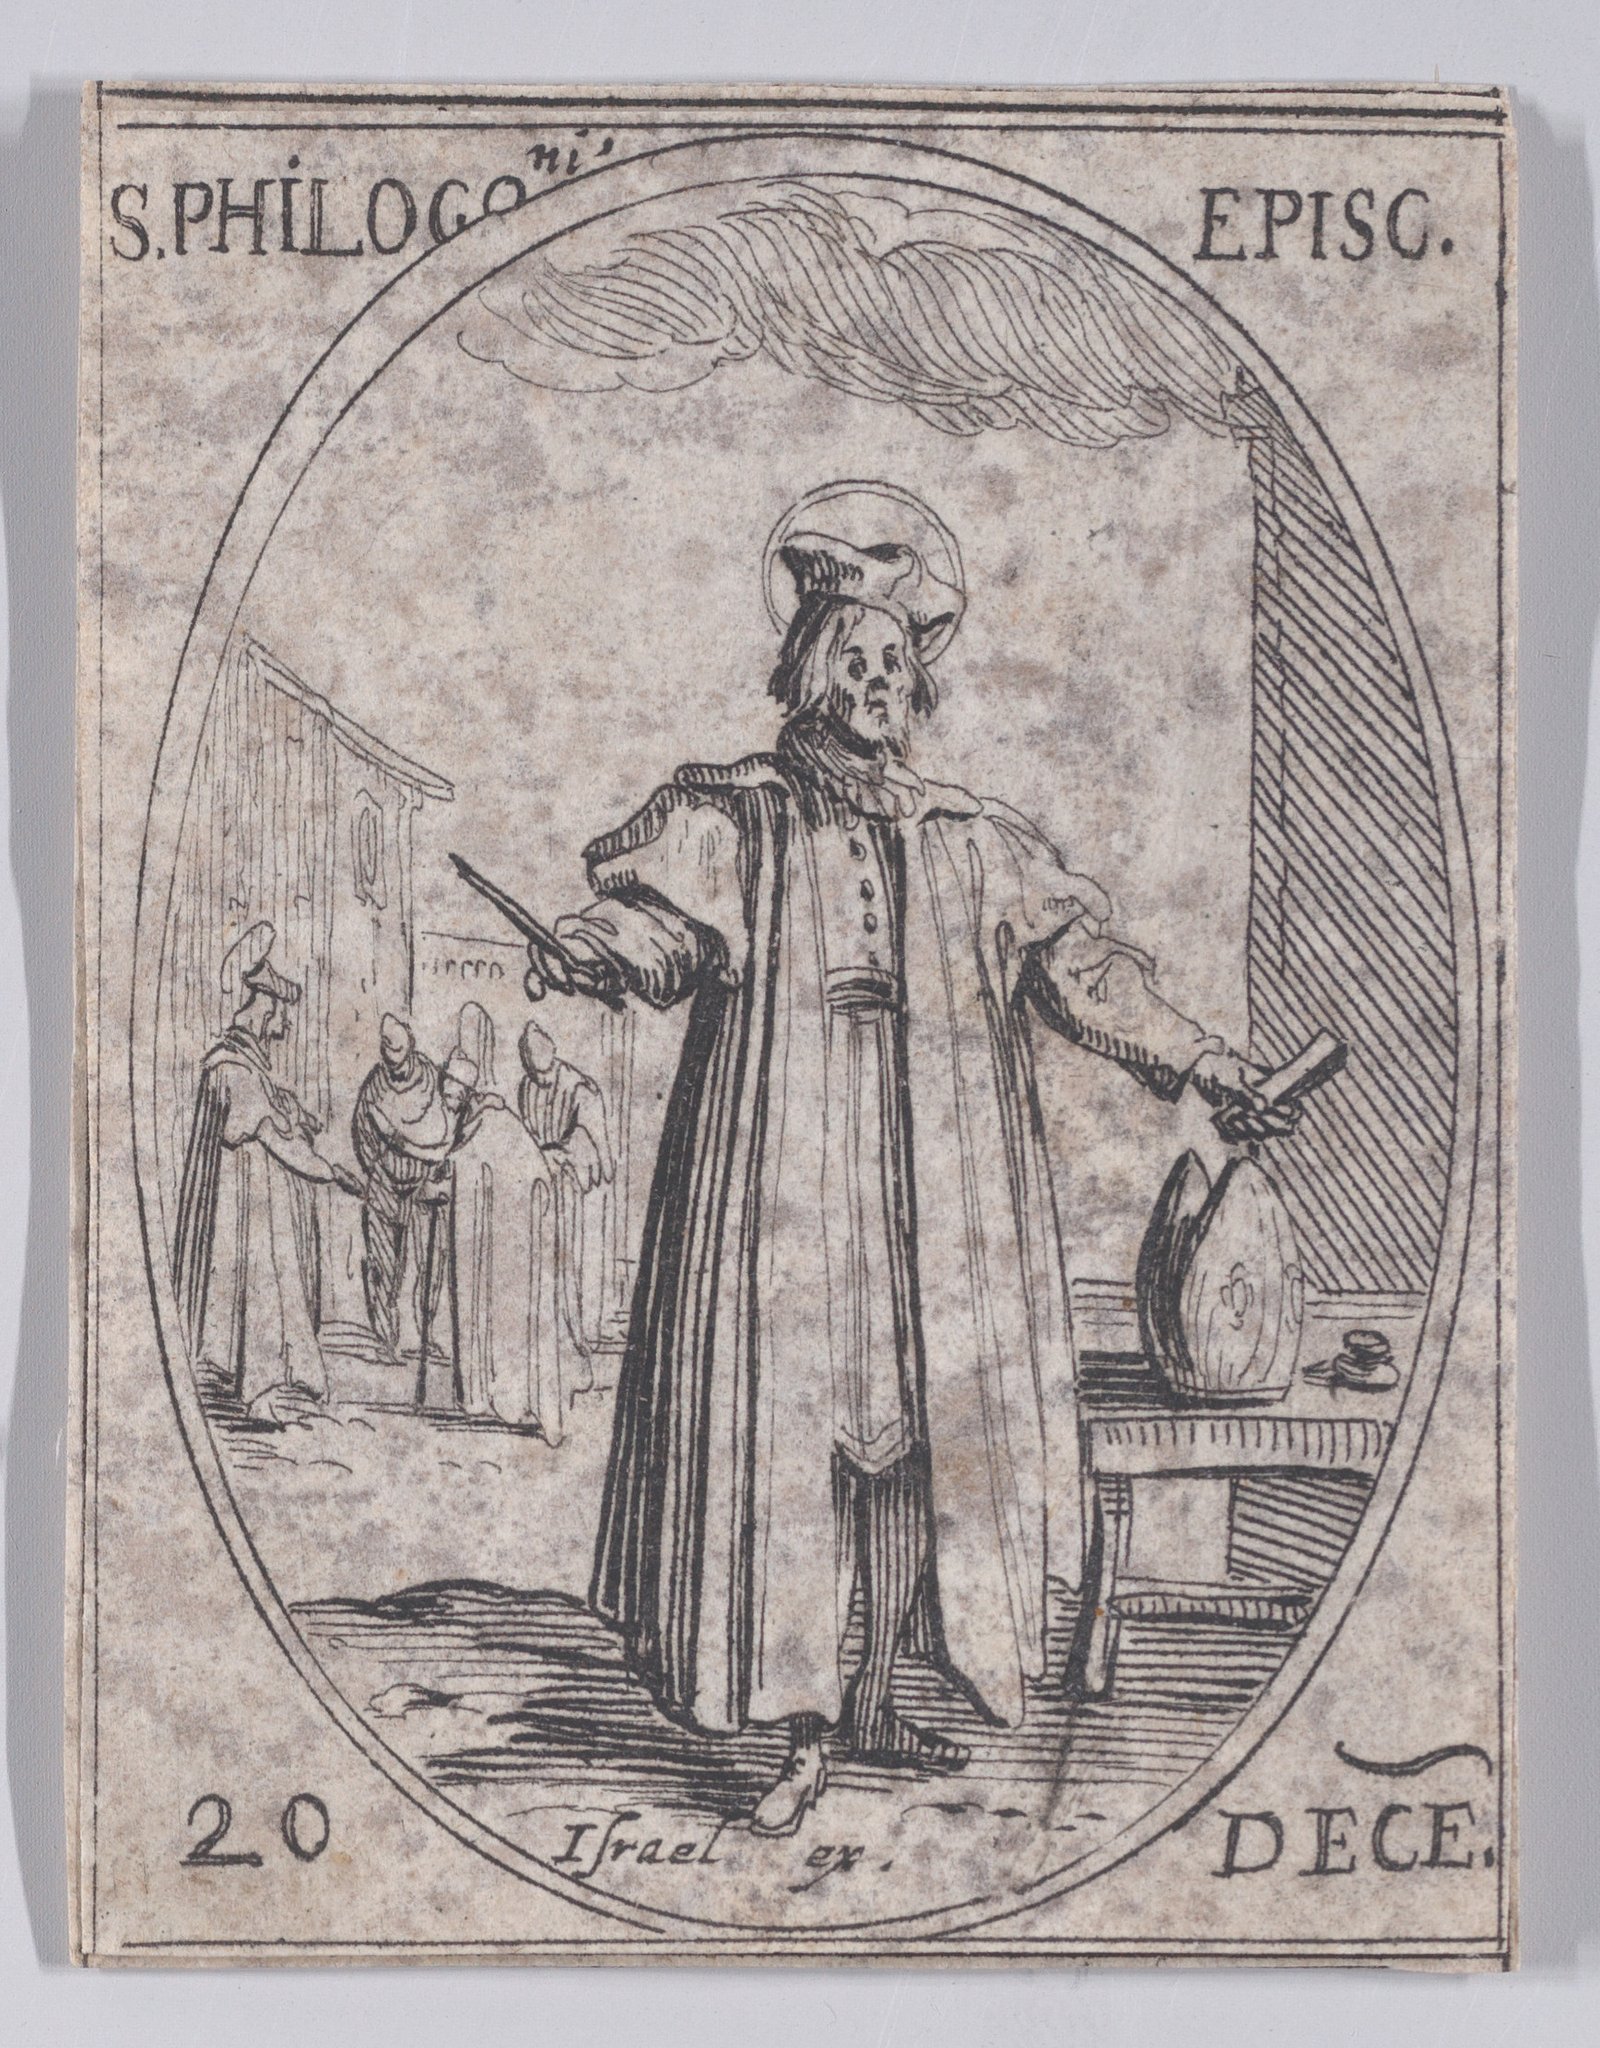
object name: print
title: S. Philogone, évêque (St. Philogonius, Bishop), December 20th, from "Les Images De Tous Les Saincts et Saintes de L'Année" (Images of All of the Saints and Religious Events of the Year)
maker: jacques callot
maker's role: artist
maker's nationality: french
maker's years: 1592-1635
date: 1636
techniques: etching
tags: men,saints